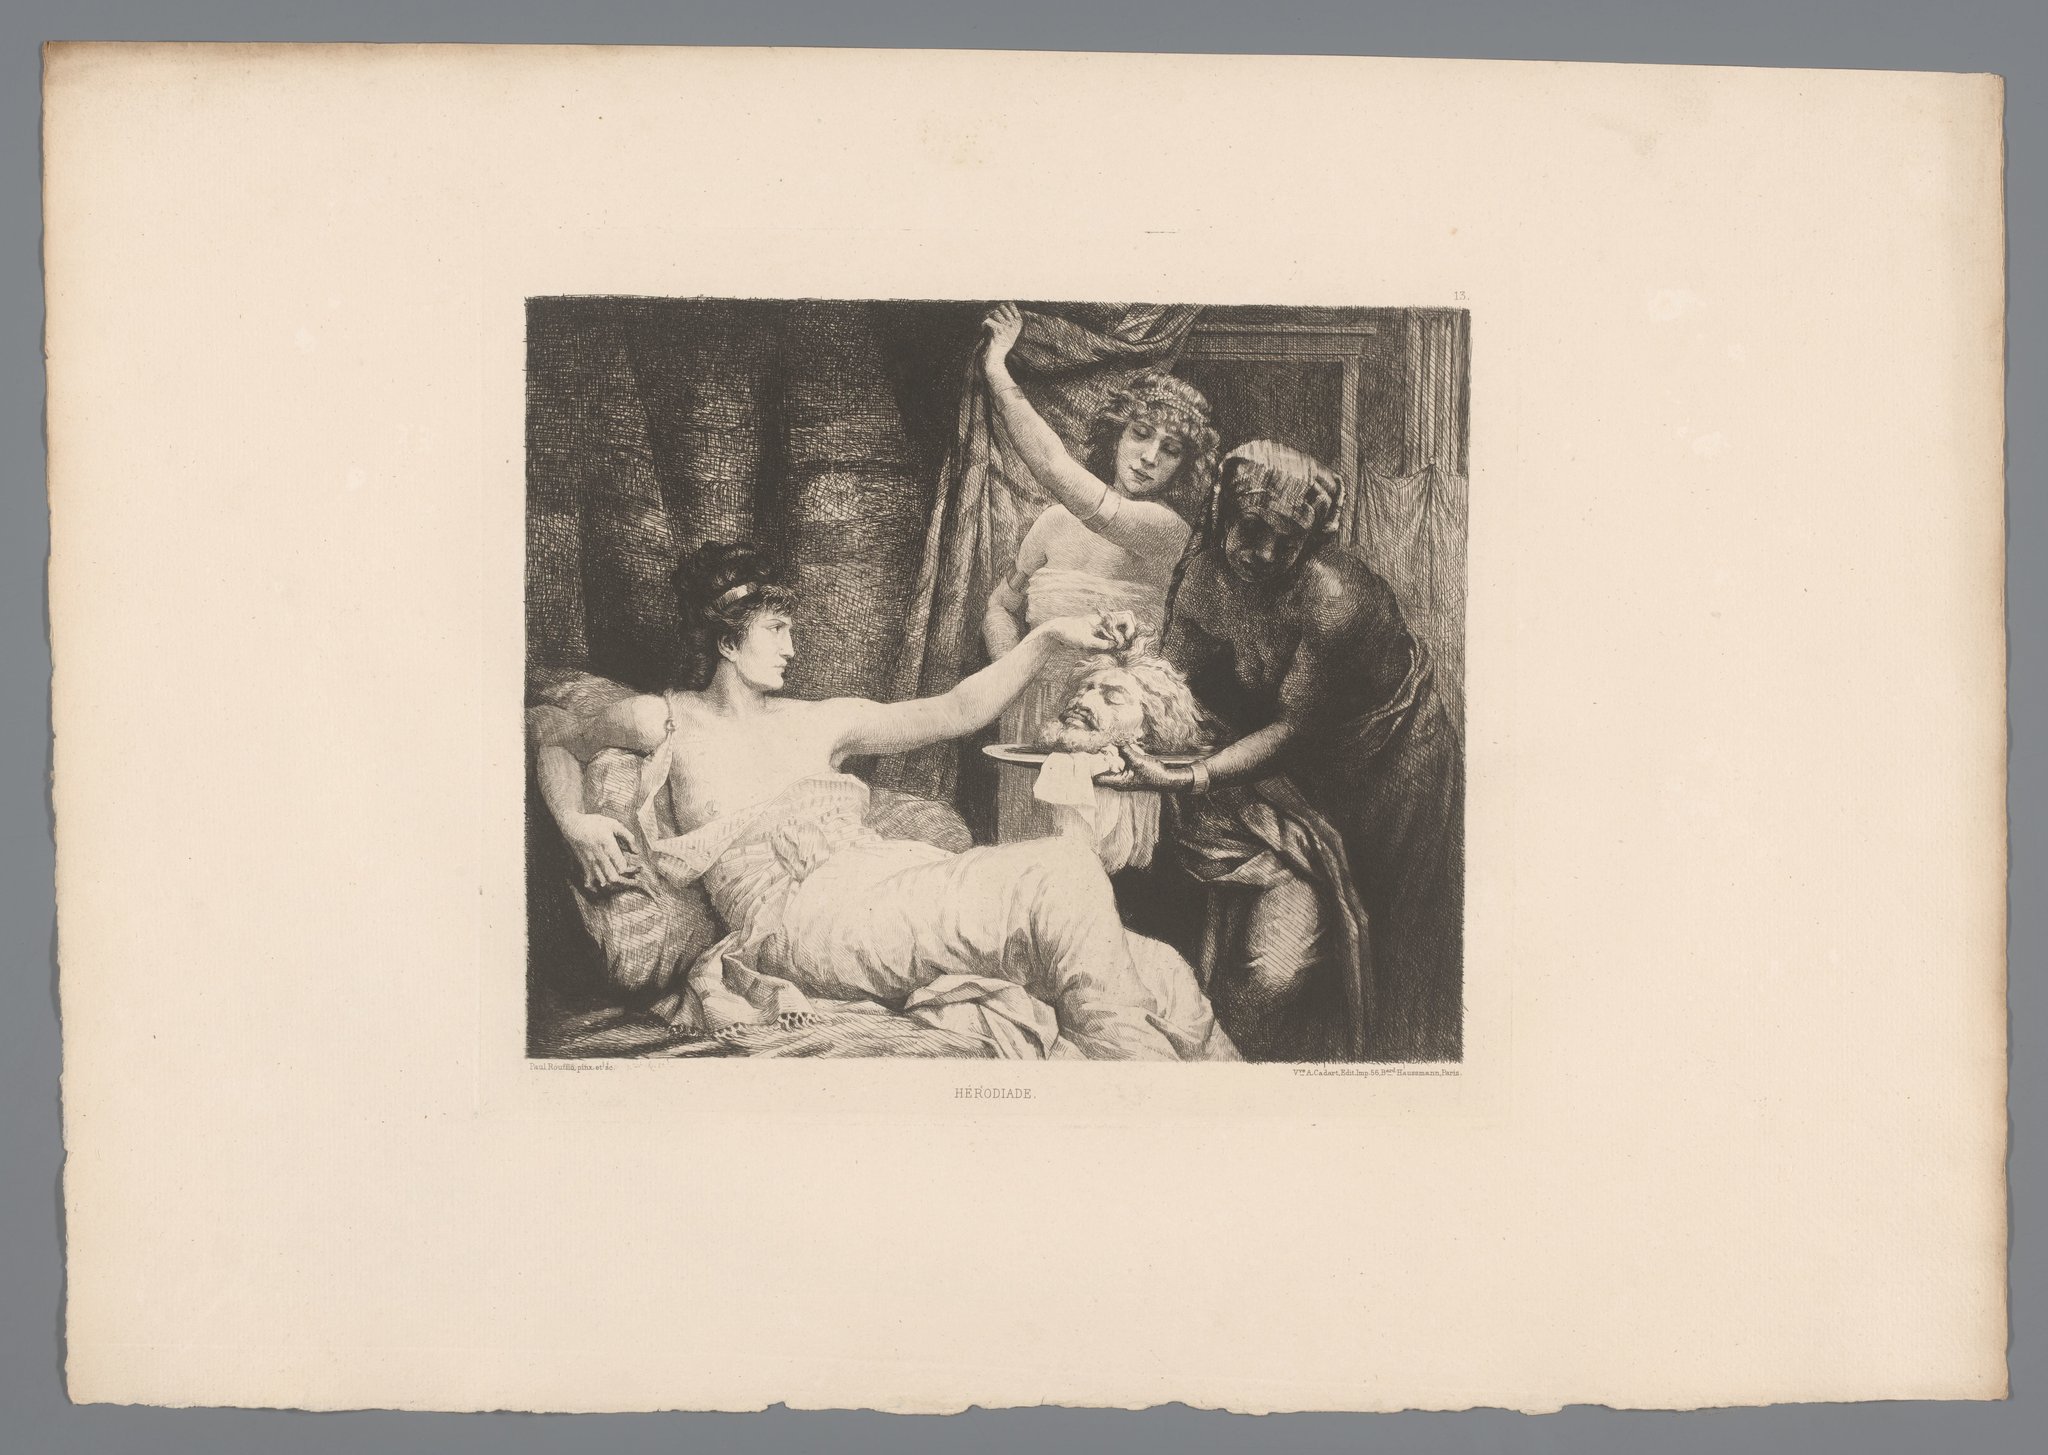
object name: print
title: Franse etsen uit 1878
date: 1878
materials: paper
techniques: drypoint, etching, intaglio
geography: paris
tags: the head of john the baptist on a platter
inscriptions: watermark, collector's mark: ‘AFE v S’, collector's mark: Lugt 2760, collector's mark: Lugt 2228